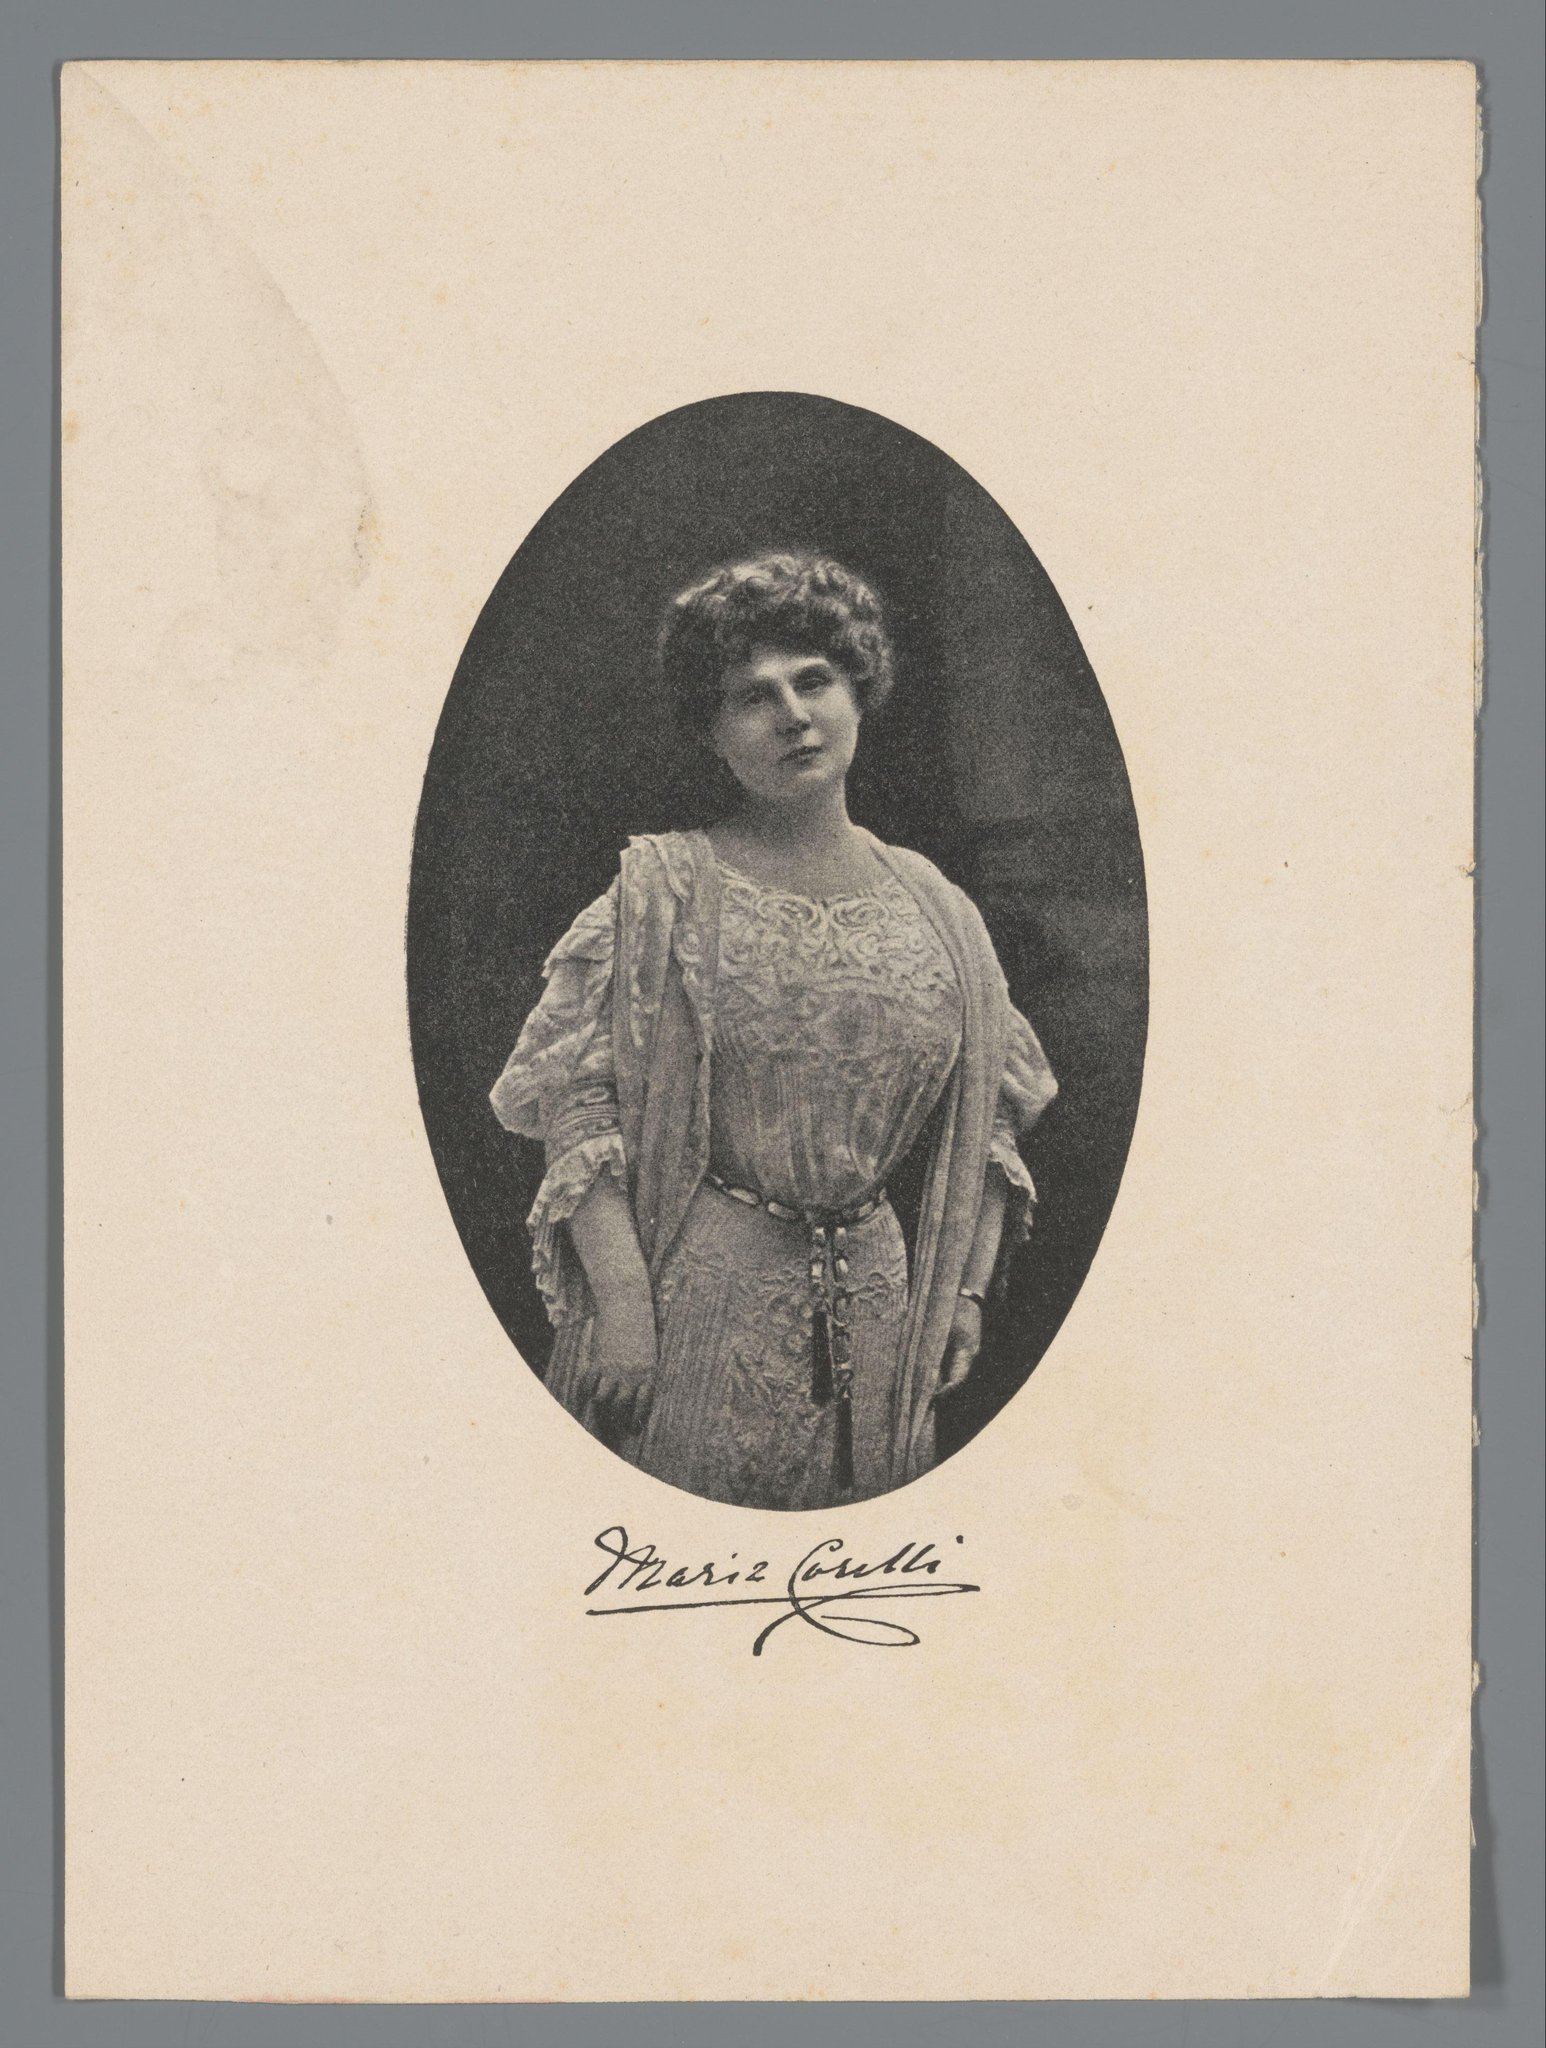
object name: photomechanical print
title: Portret van Marie Corelli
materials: paper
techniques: autotype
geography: london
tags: portrait of a writer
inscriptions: name: ‘Marie Corelli’